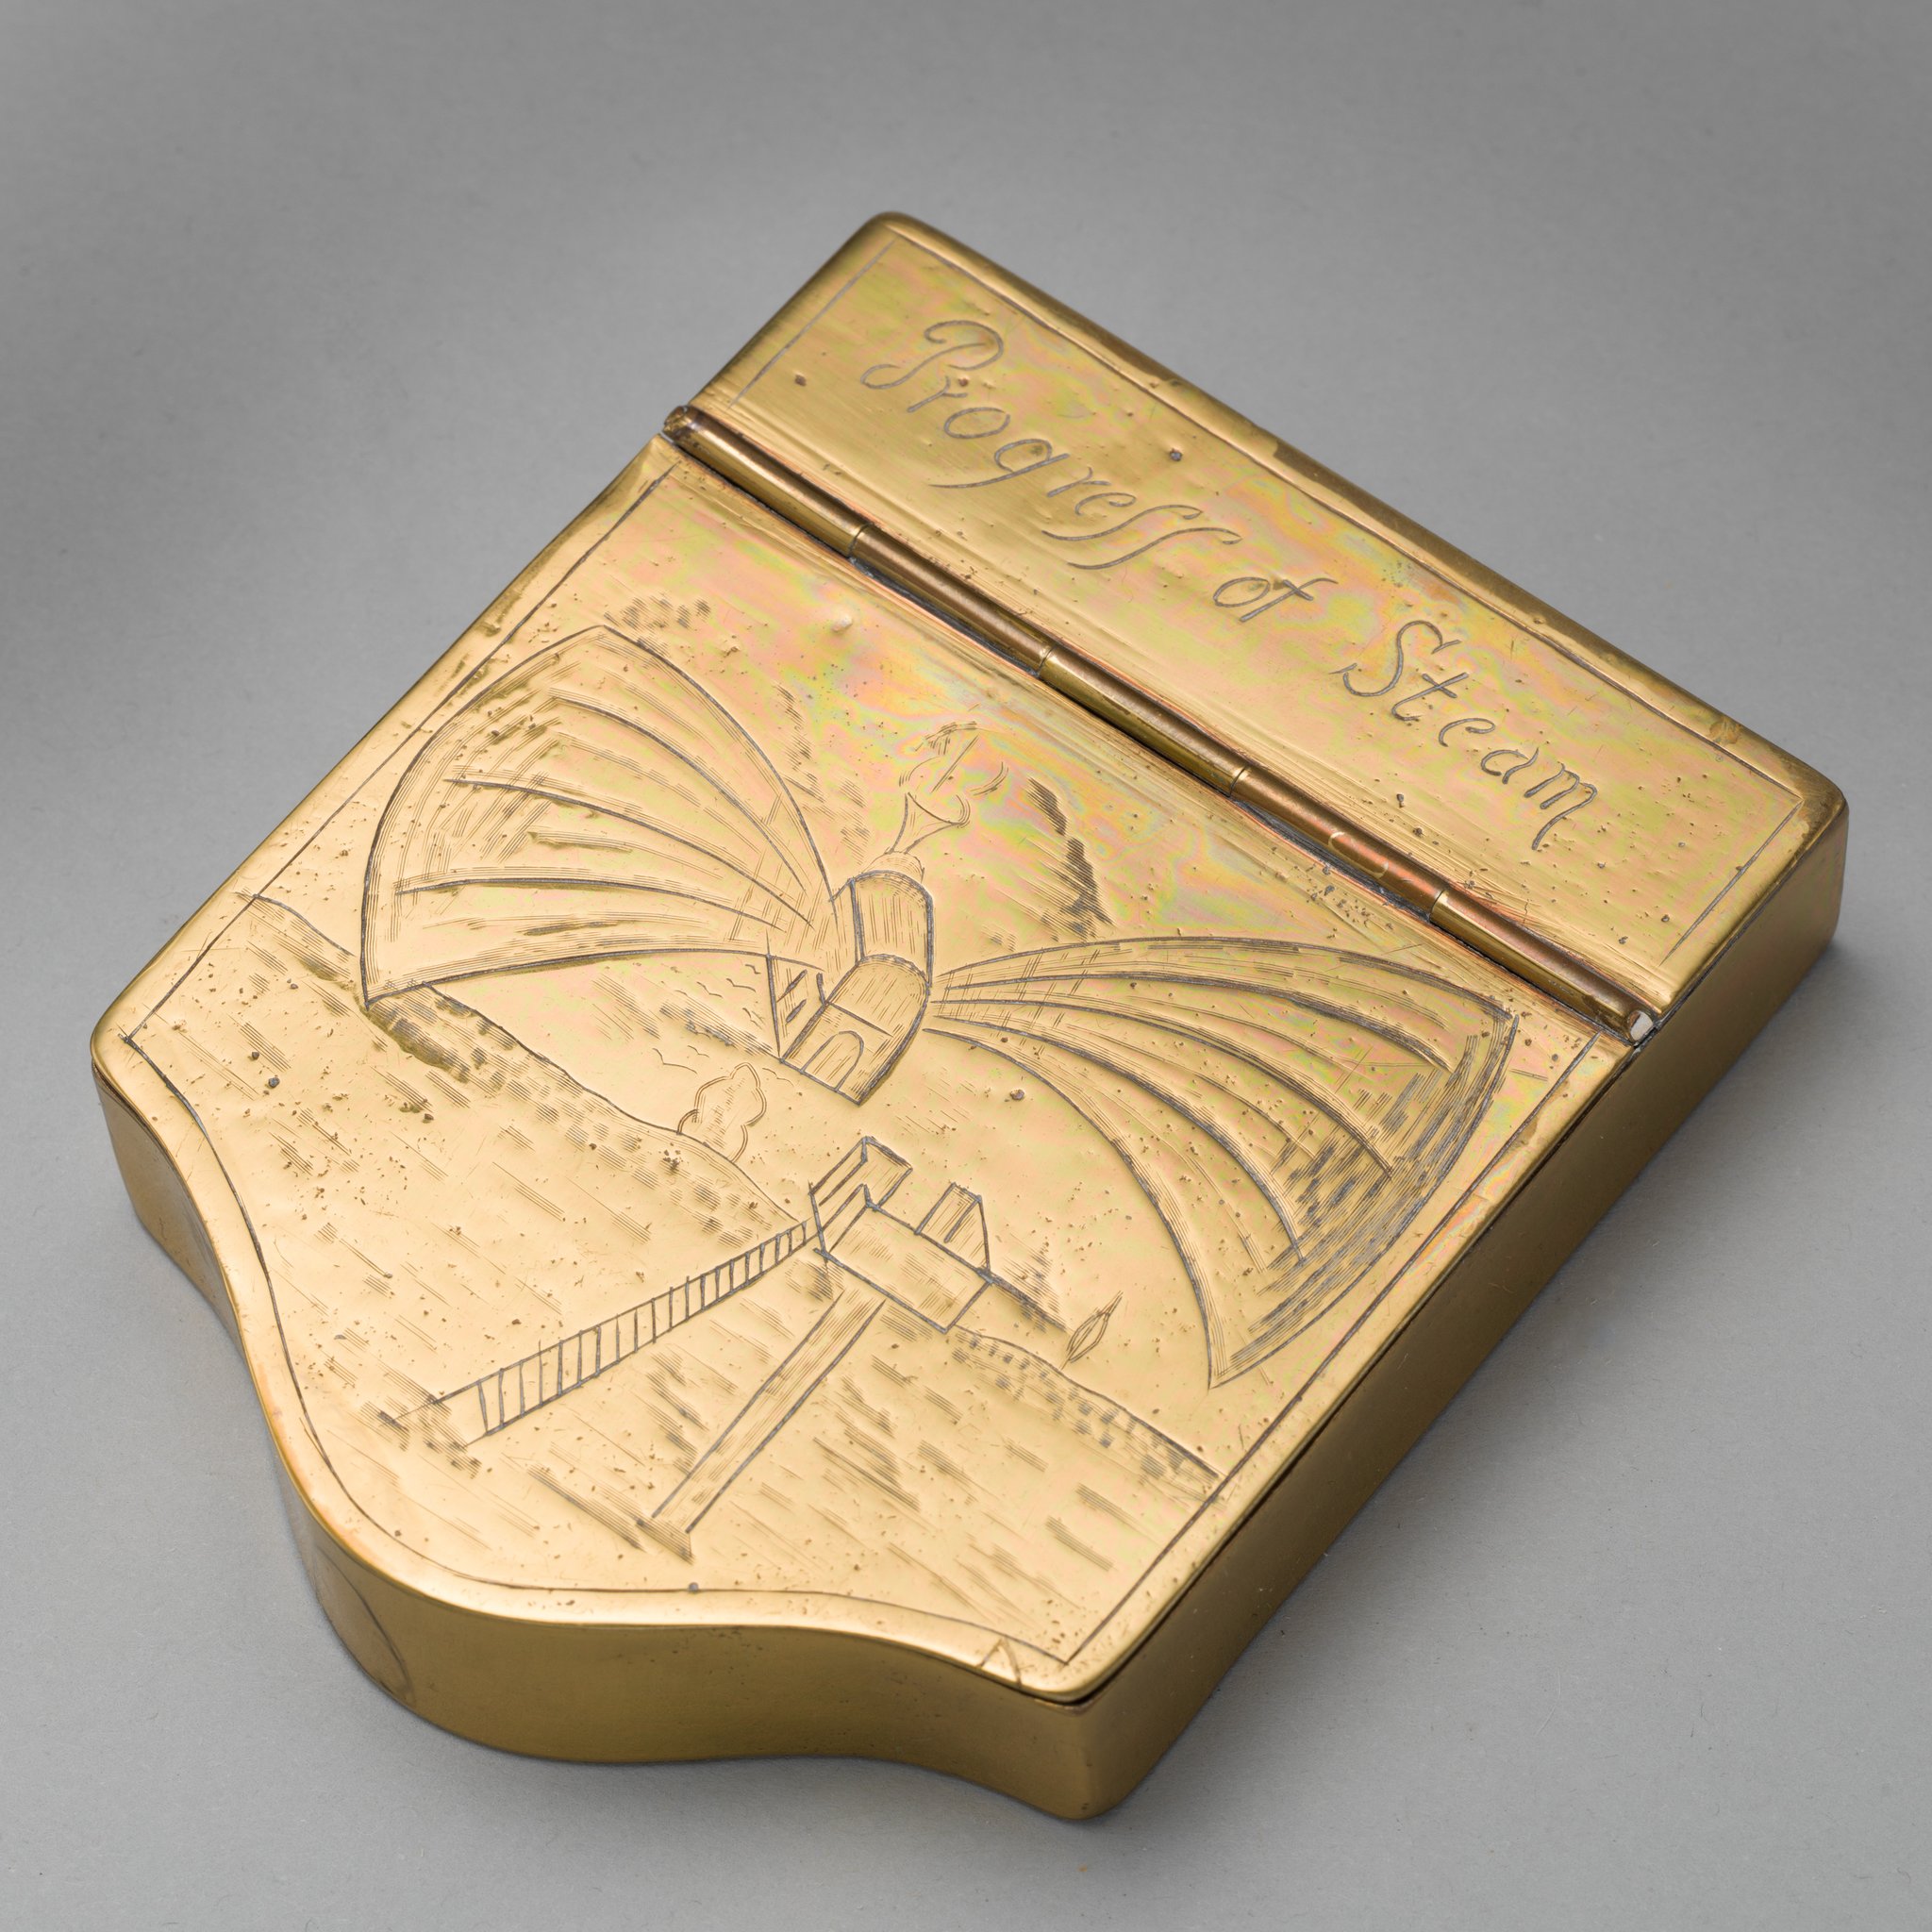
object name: tobacco box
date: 1767-1800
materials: brass